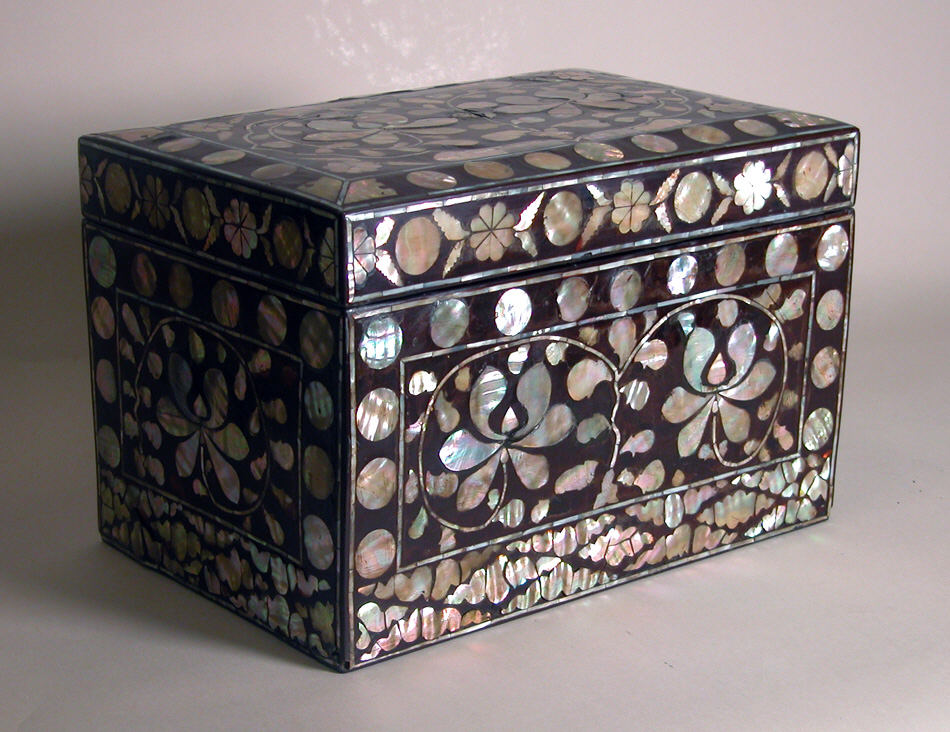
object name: box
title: Box decorated with flowers and clouds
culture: korean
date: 1701-1800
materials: lacquer, mother of pearl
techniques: inlay